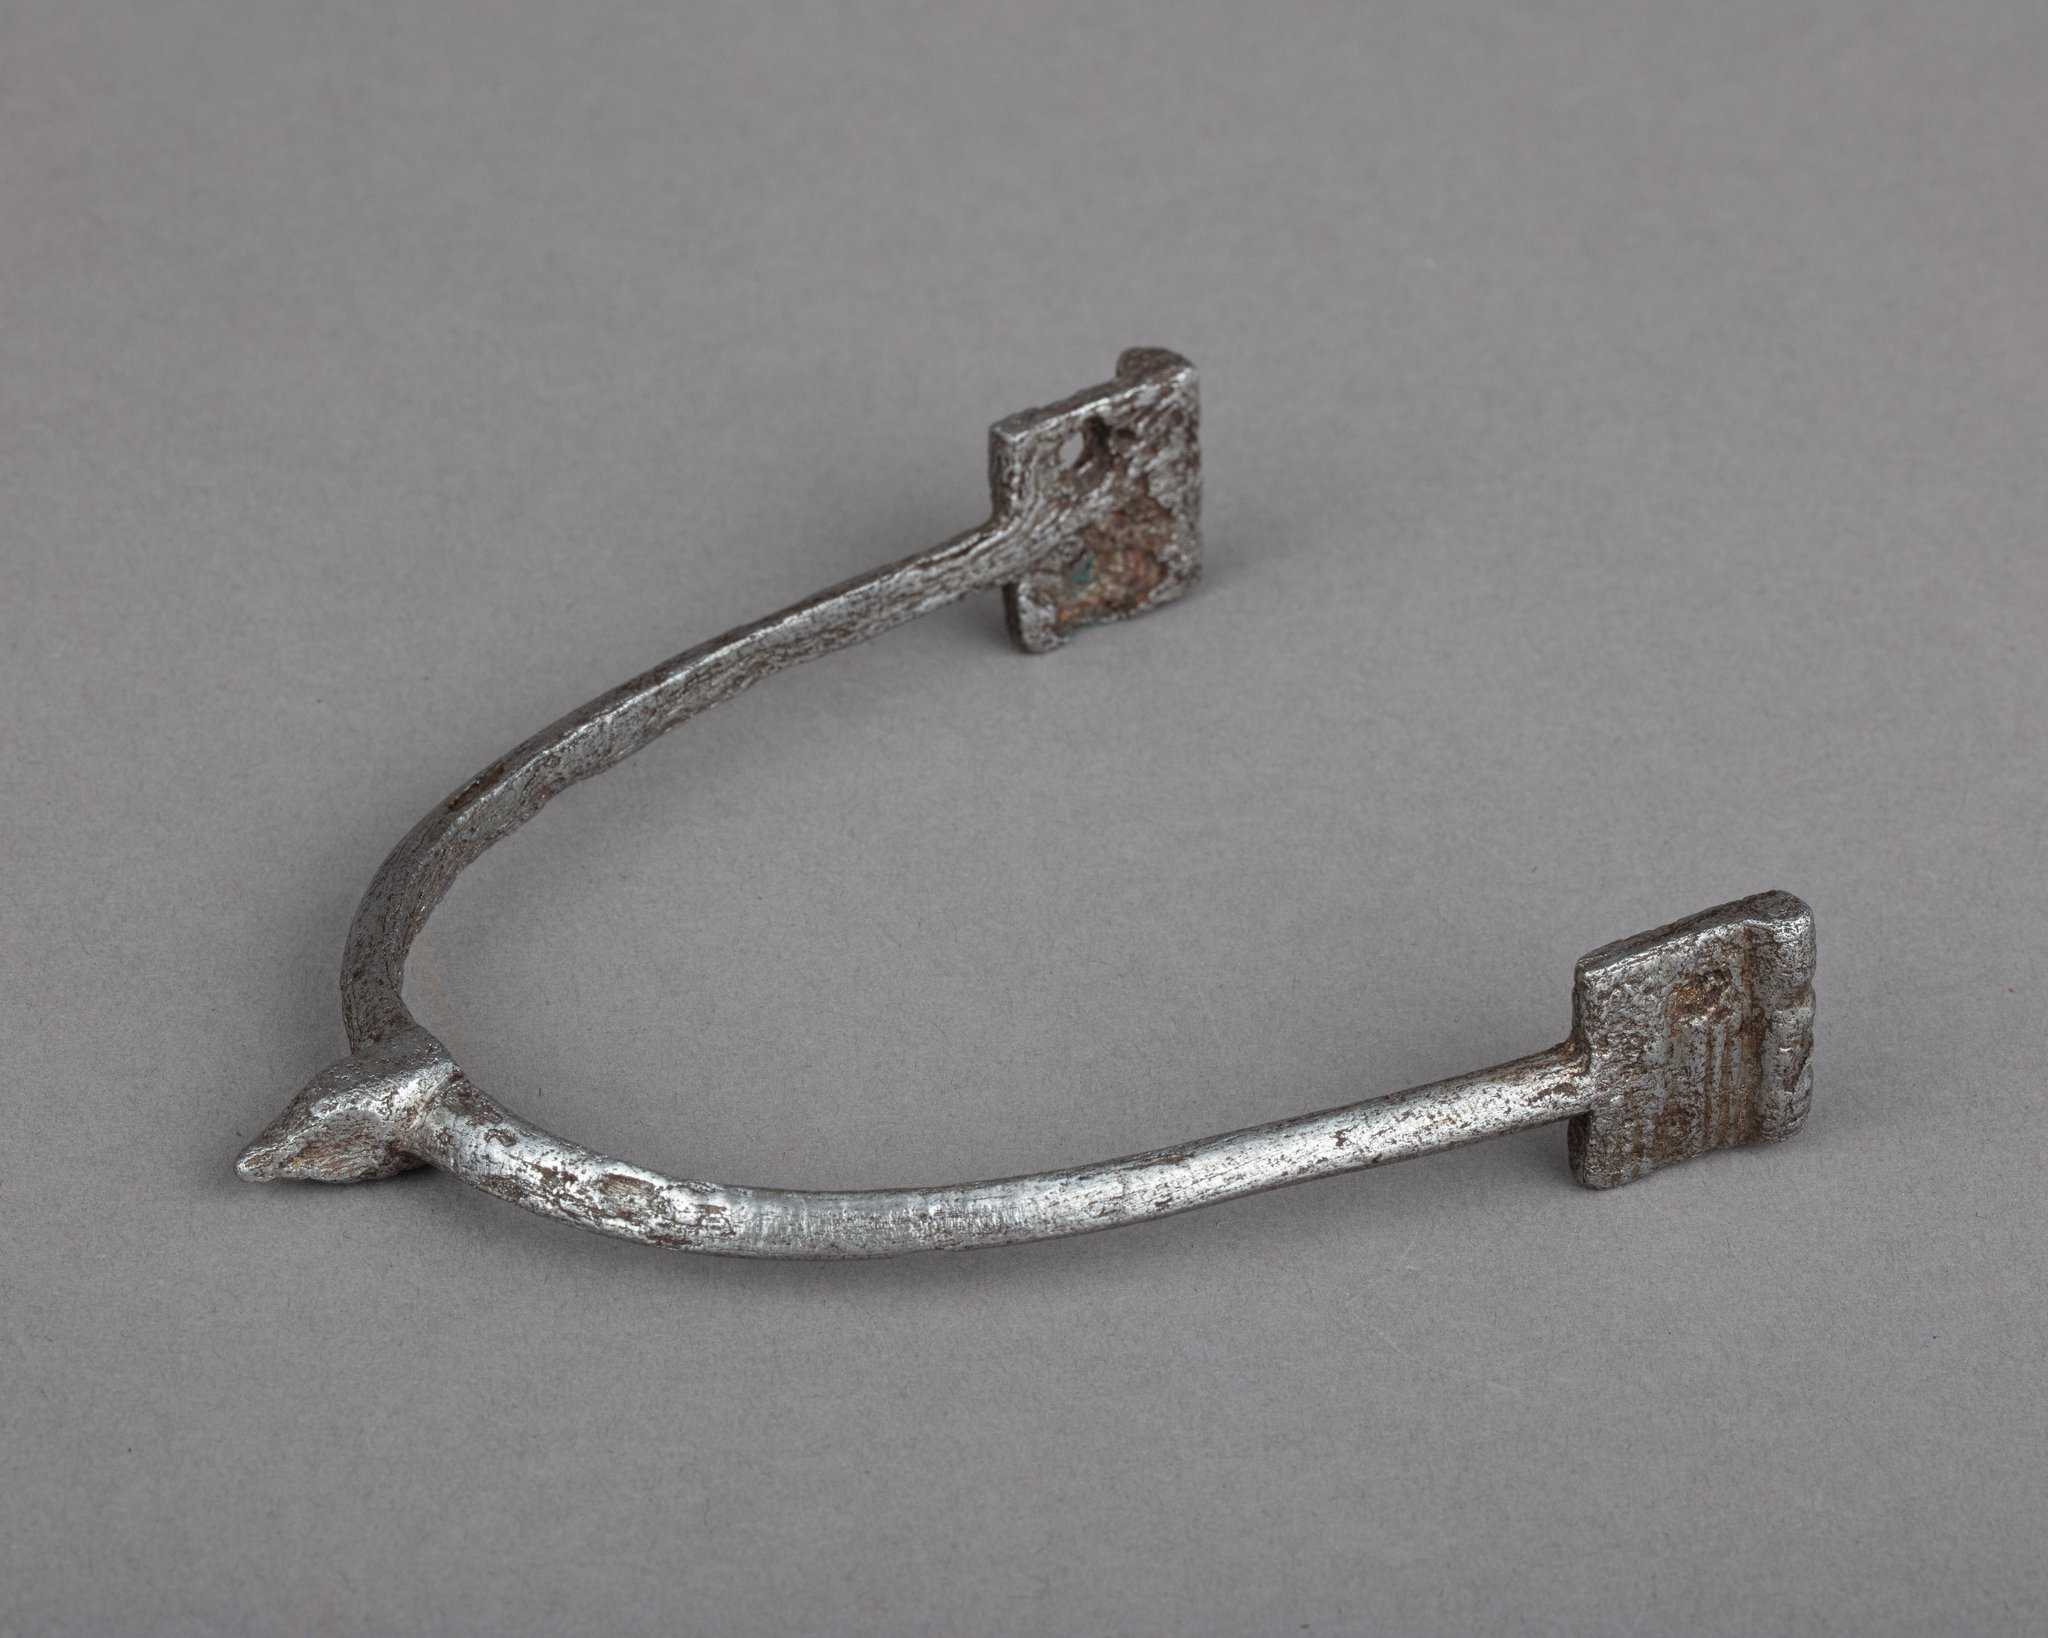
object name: spur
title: Prick Spur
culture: eastern european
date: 801-900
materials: metal alloy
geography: germany